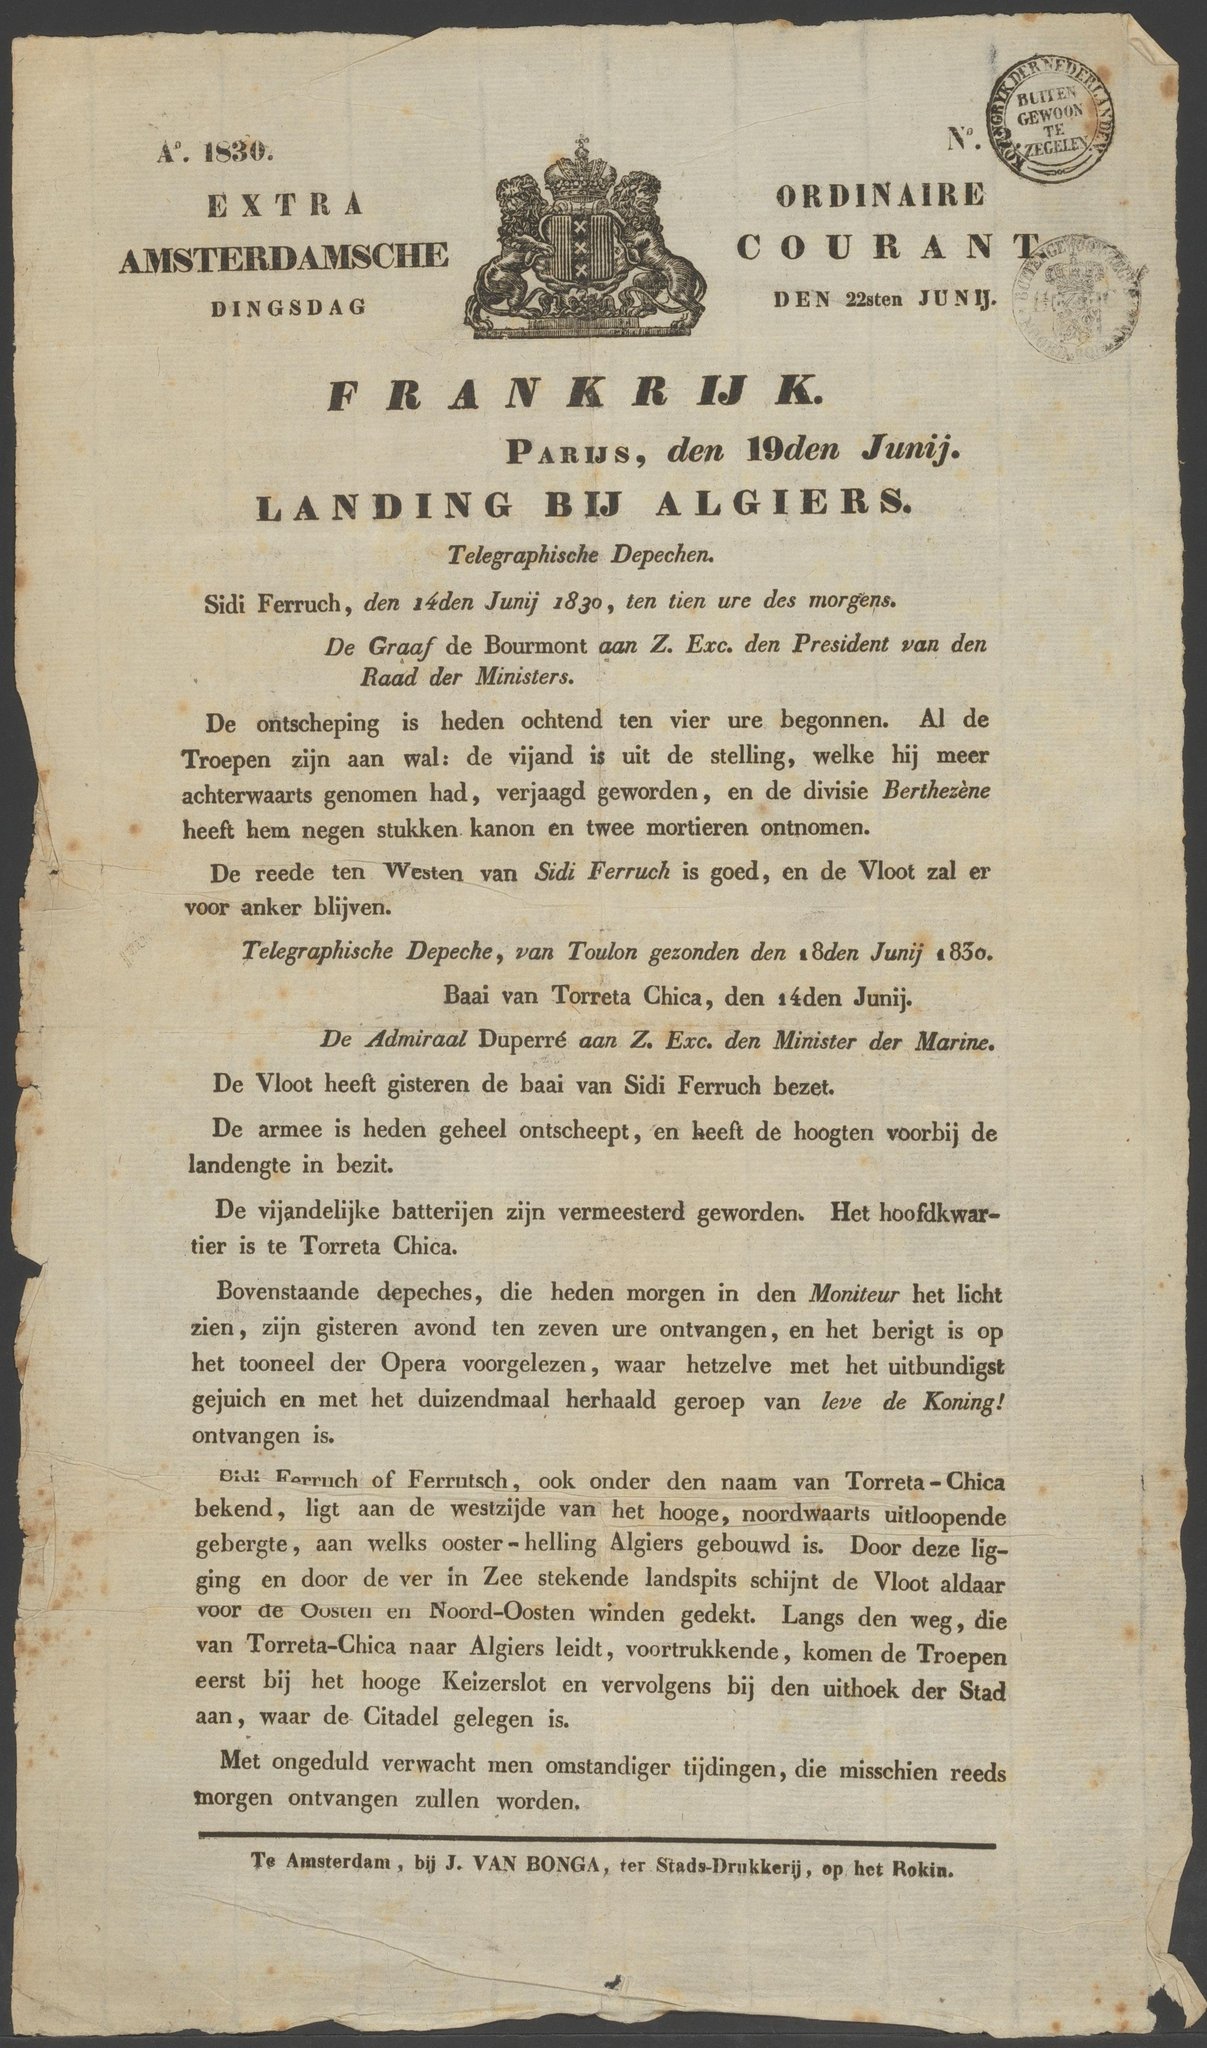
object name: newspaper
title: Extra-Ordinaire Amsterdamsche Courant, 22 juni 1830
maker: jacobus van bonga jr.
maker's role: printer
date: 1830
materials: paper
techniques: letterpress printing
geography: amsterdam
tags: newspaper, news-sheet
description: Exemplaar van de krant 'Extra-Ordinaire Amsterdamsche Courant' van 22 juni 1830. Enkelbladig, één zijde bedrukt. Bovenaan een vignet met het stadswapen. Rechtsboven twee stempels betaalde accijnzen. Onderwerpsrubrieken binnen de Atlas Zeden en Gewoonten: Regeering, Officieele Nieuwsbladen.